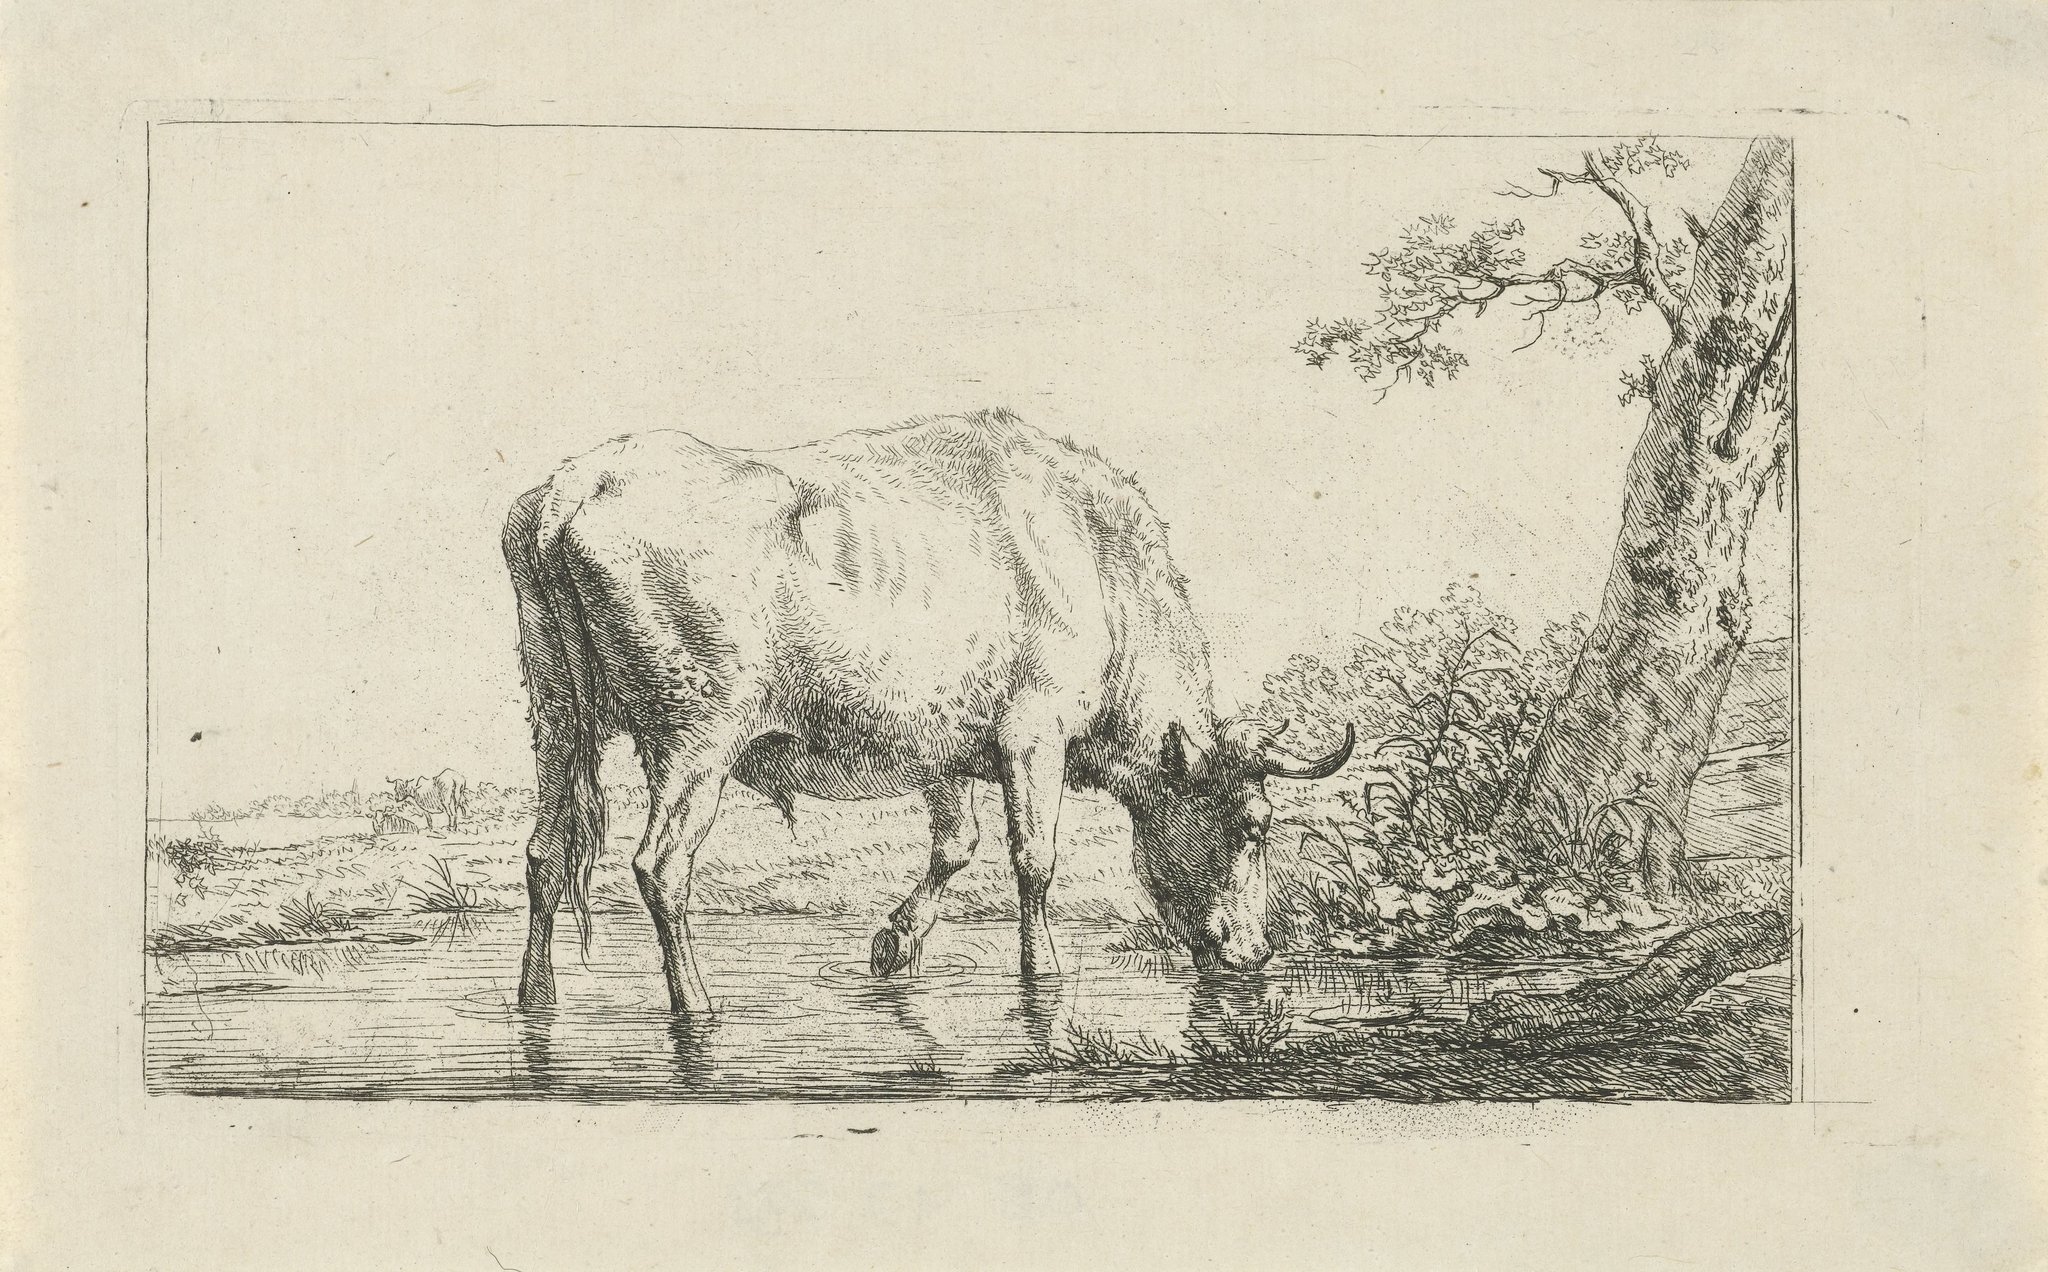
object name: print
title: Drinkende stier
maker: jan kobell (ii)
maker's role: draughtsman, painter, print maker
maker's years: 1778-1814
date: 1788-1814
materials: paper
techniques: etching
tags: cow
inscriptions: collector's mark: Lugt 2228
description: In een landschap staat een stier bij een boom uit een waterplas te drinken, waar hij tot zijn enkels in staat. Op de achtergrond twee grazende koeien.